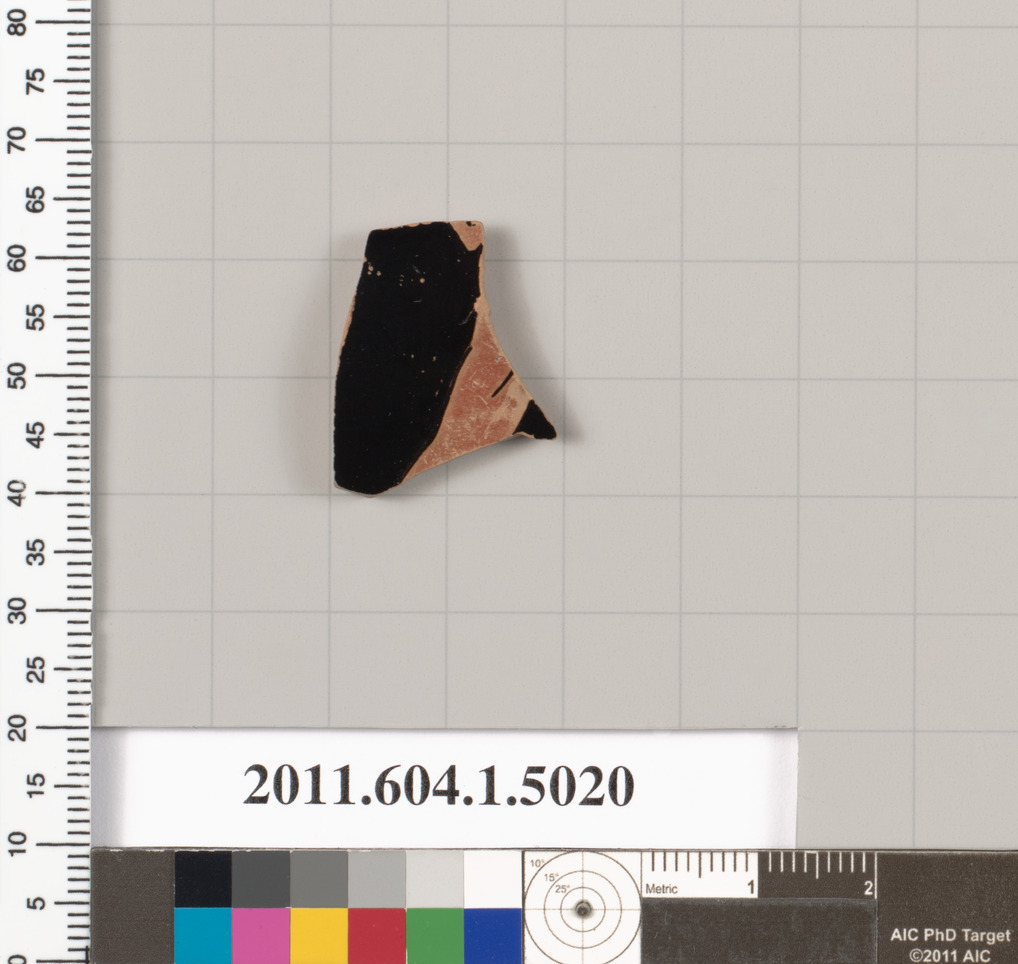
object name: kylix fragment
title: Terracotta fragment of a kylix (drinking cup)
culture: greek, attic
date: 490-470 BCE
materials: terracotta